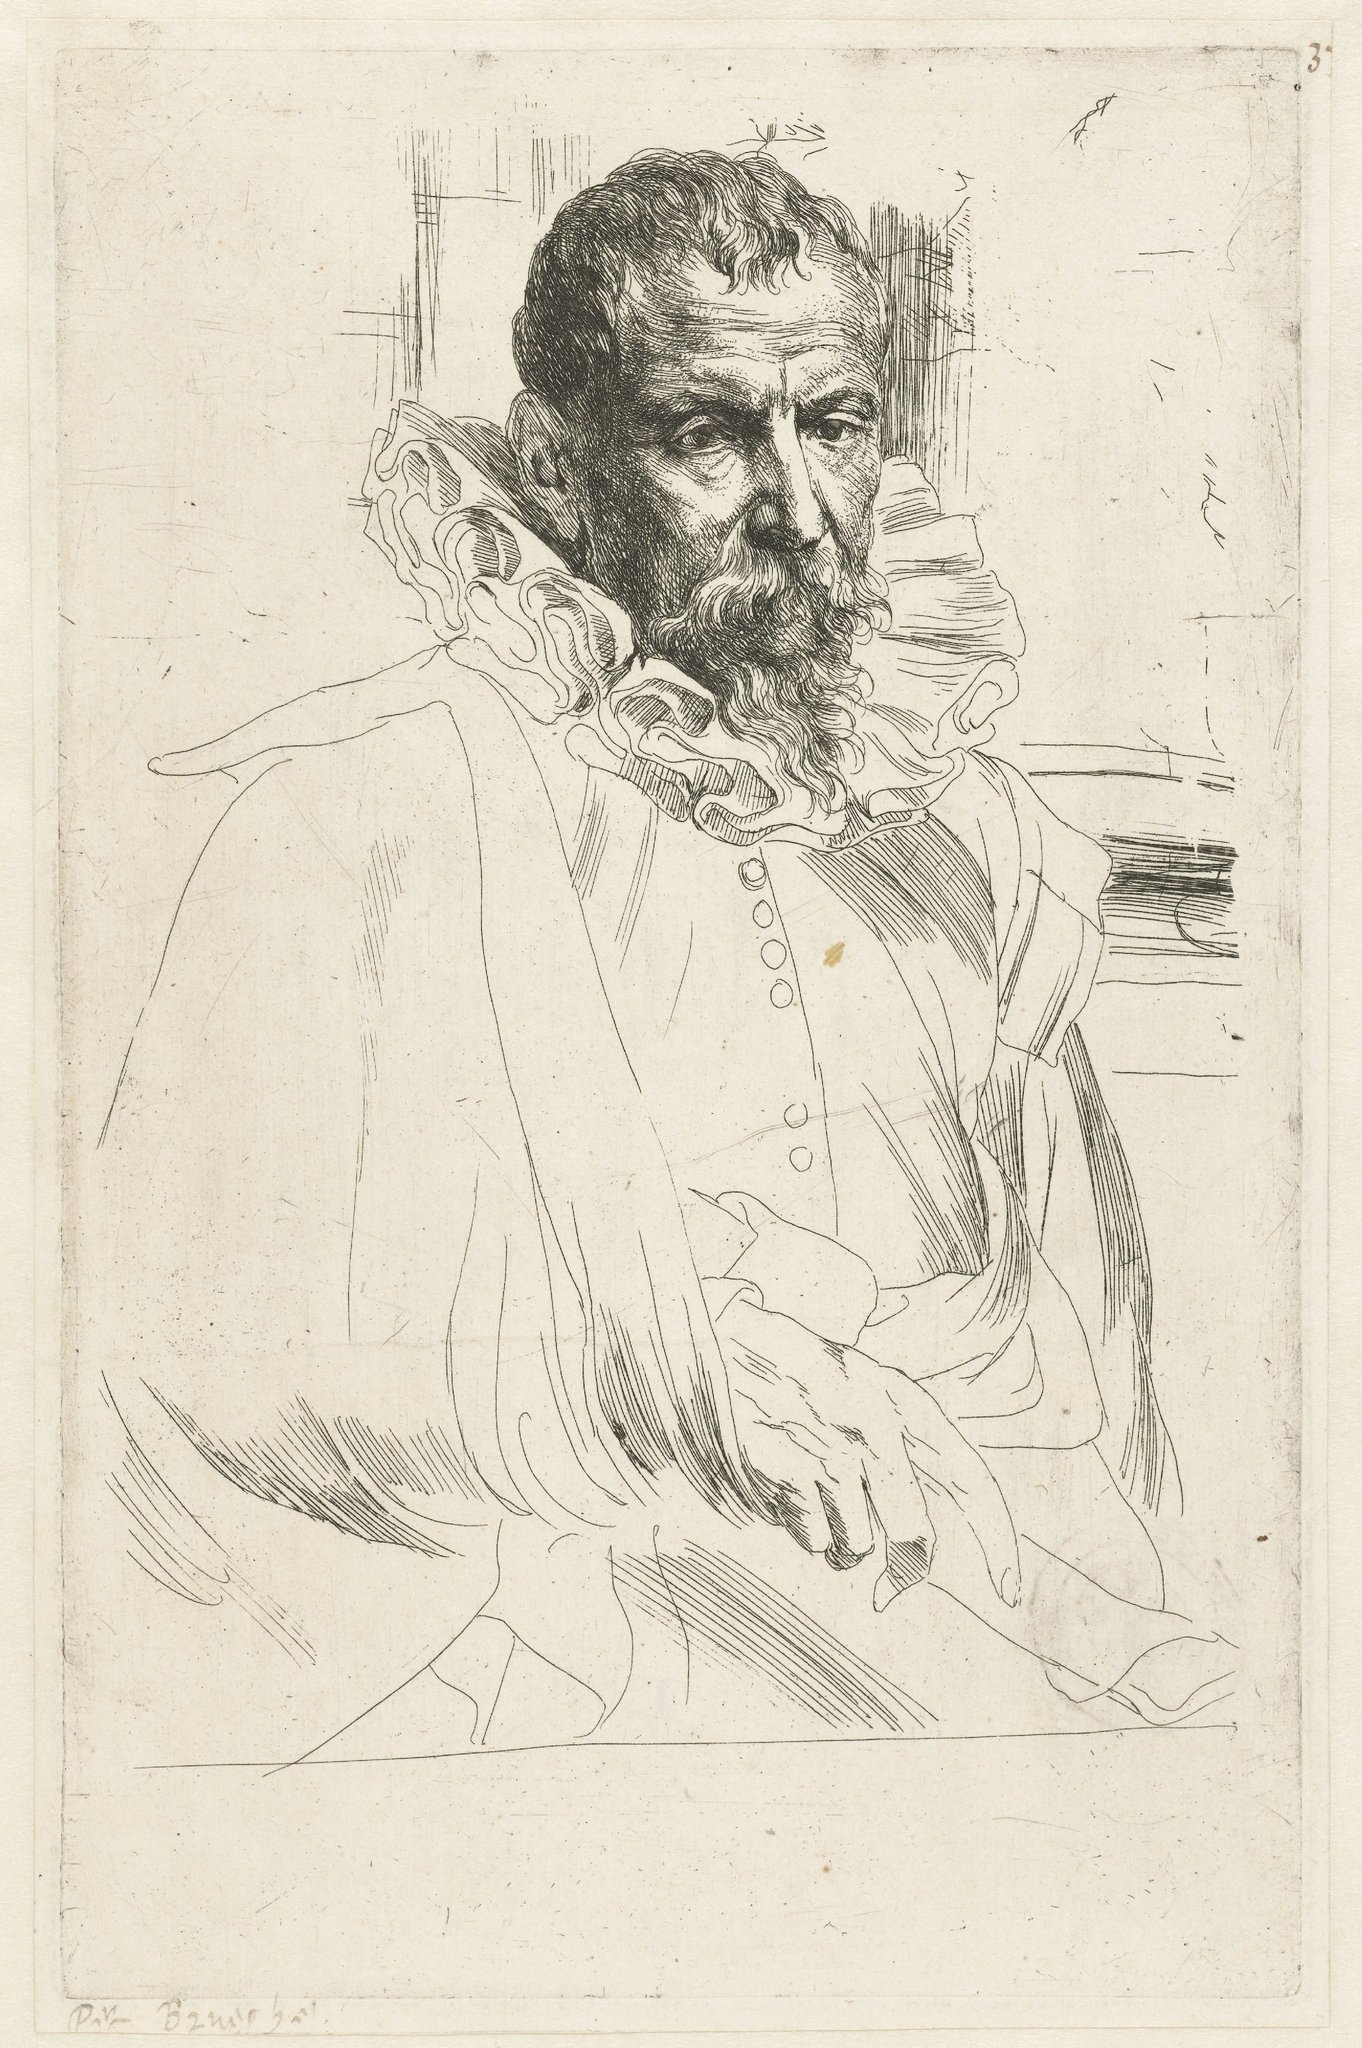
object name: print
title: Iconographie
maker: anthony van dyck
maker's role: draughtsman, painter, print maker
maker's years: 1599-1641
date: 1630-1632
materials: paper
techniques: etching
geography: low countries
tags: brussels, pieter brueghel (ii), portrait, self-portrait of painter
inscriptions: inscription: ‘Pier Brueghel’, collector's mark: Lugt 240